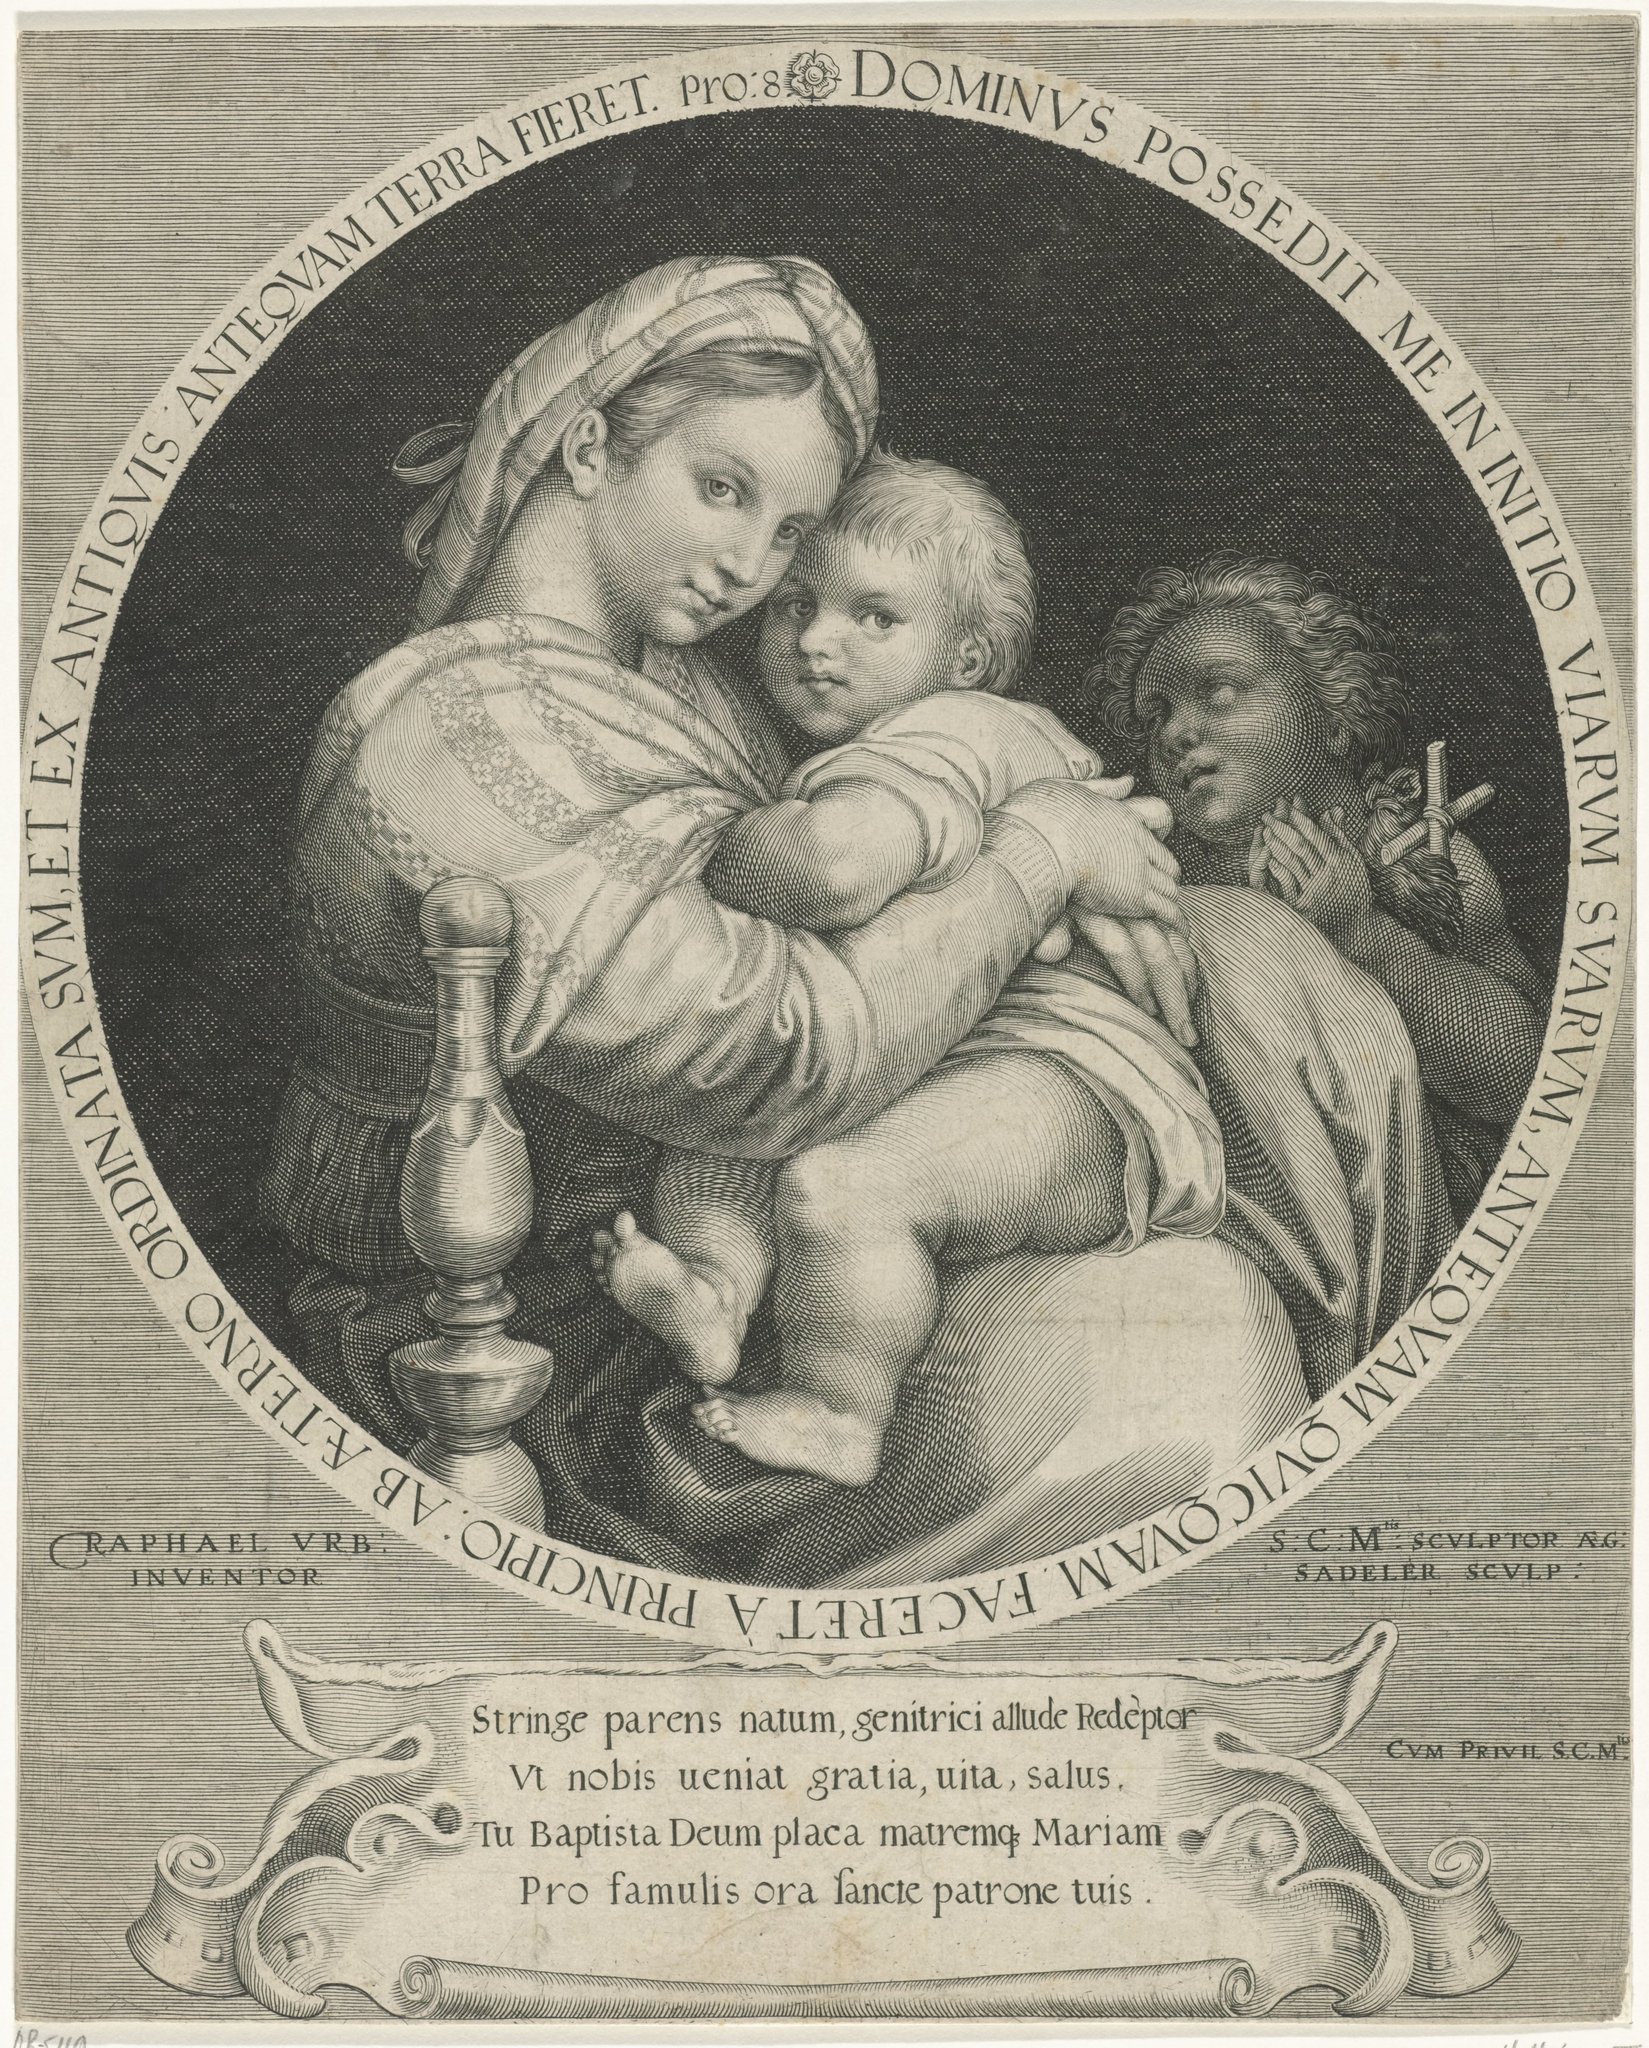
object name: print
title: Maria en kind met Johannes de Doper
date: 1580-1629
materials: paper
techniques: engraving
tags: mary and the christ-child with john the baptist (as child)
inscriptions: collector's mark: Lugt 240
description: In een rond kader Maria met het Christuskind op haar schoot. Op de achtergrond de jonge Johannes de Doper. Onder het kader een Latijnse tekst in een banderol.